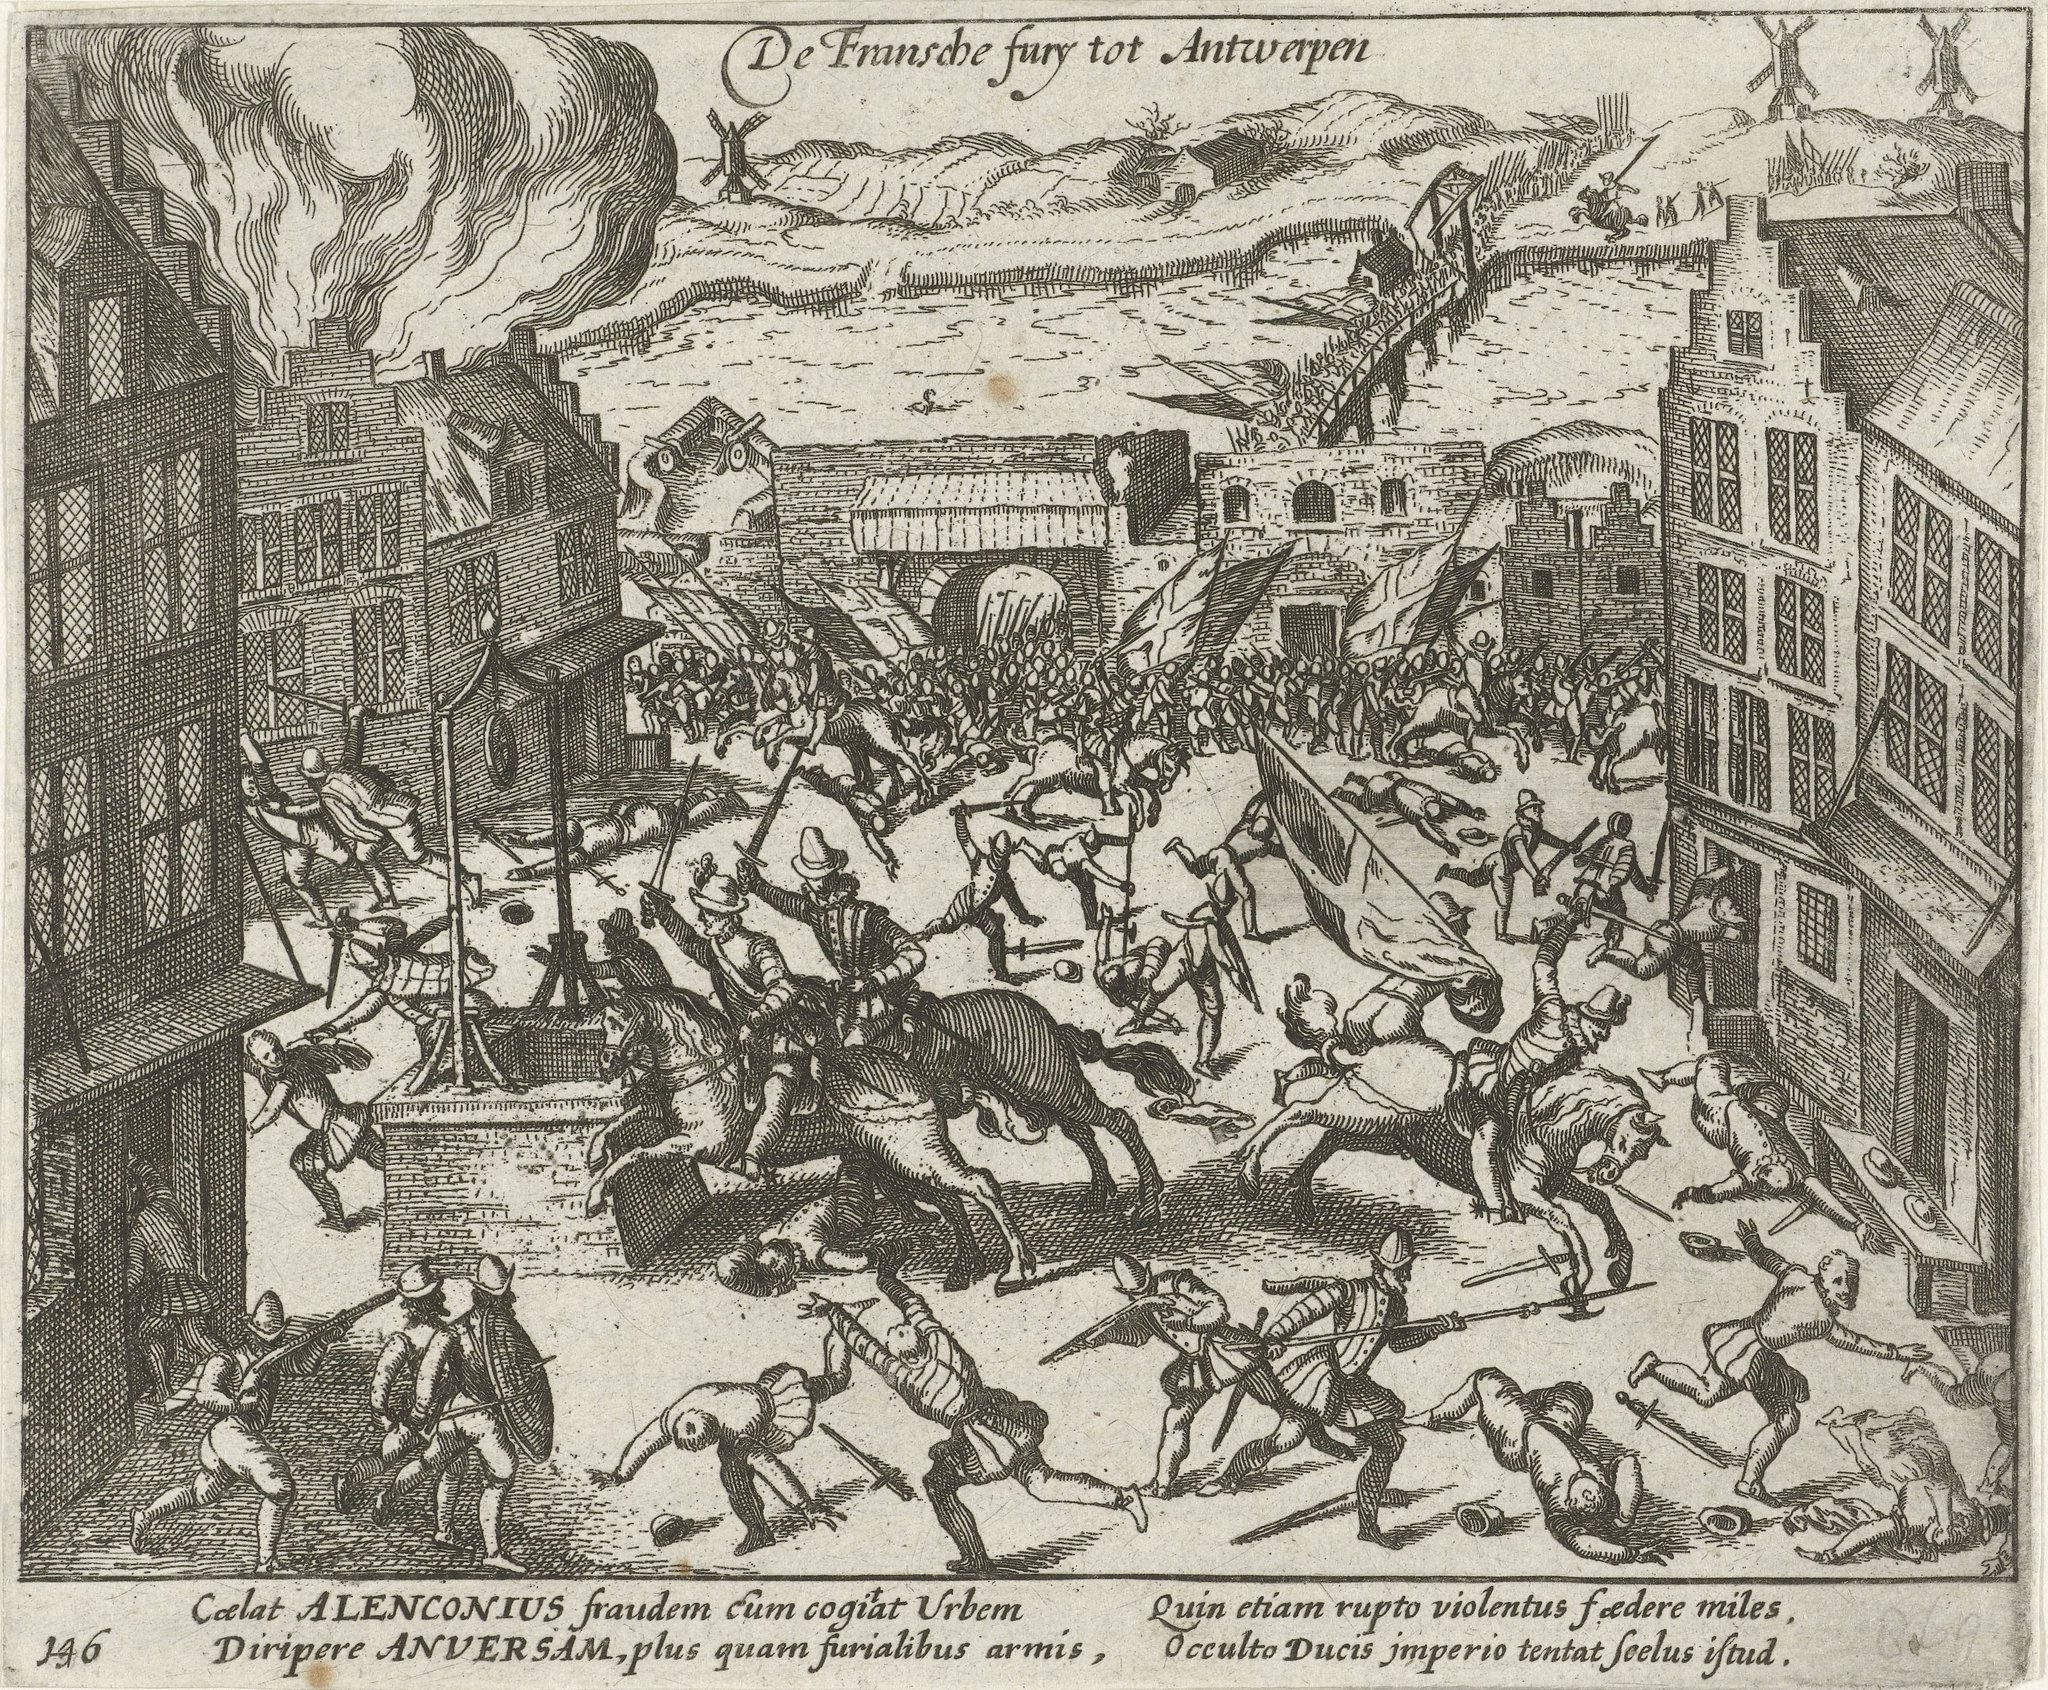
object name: history print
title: De Fransche fury tot Antwerpen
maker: Anonymous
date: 1613-1615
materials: paper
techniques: etching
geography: northern netherlands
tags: massacre ~ war, antwerp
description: De Franse Furie te Antwerpen, 17 januari 1583. Moord en plundering door Franse soldaten in de straten van Antwerpen in een poging de stad te veroveren voor de hertog van Anjou. Met onderschrift van 4 regels in het Latijn. Genummerd 146. Bedrukt op achterzijde met tekst in het Latijn.